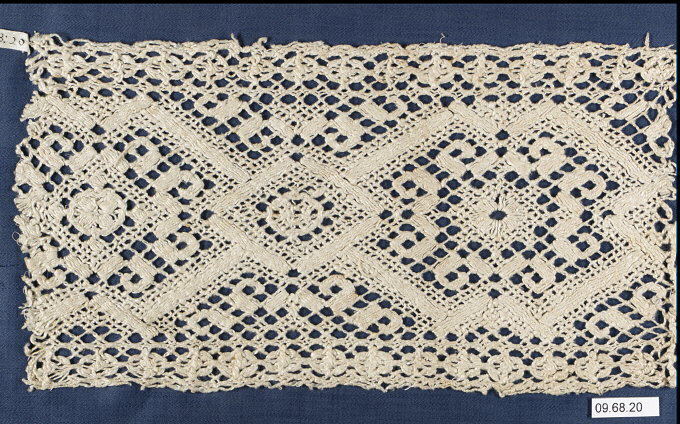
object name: insertion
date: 1600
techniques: embroidery